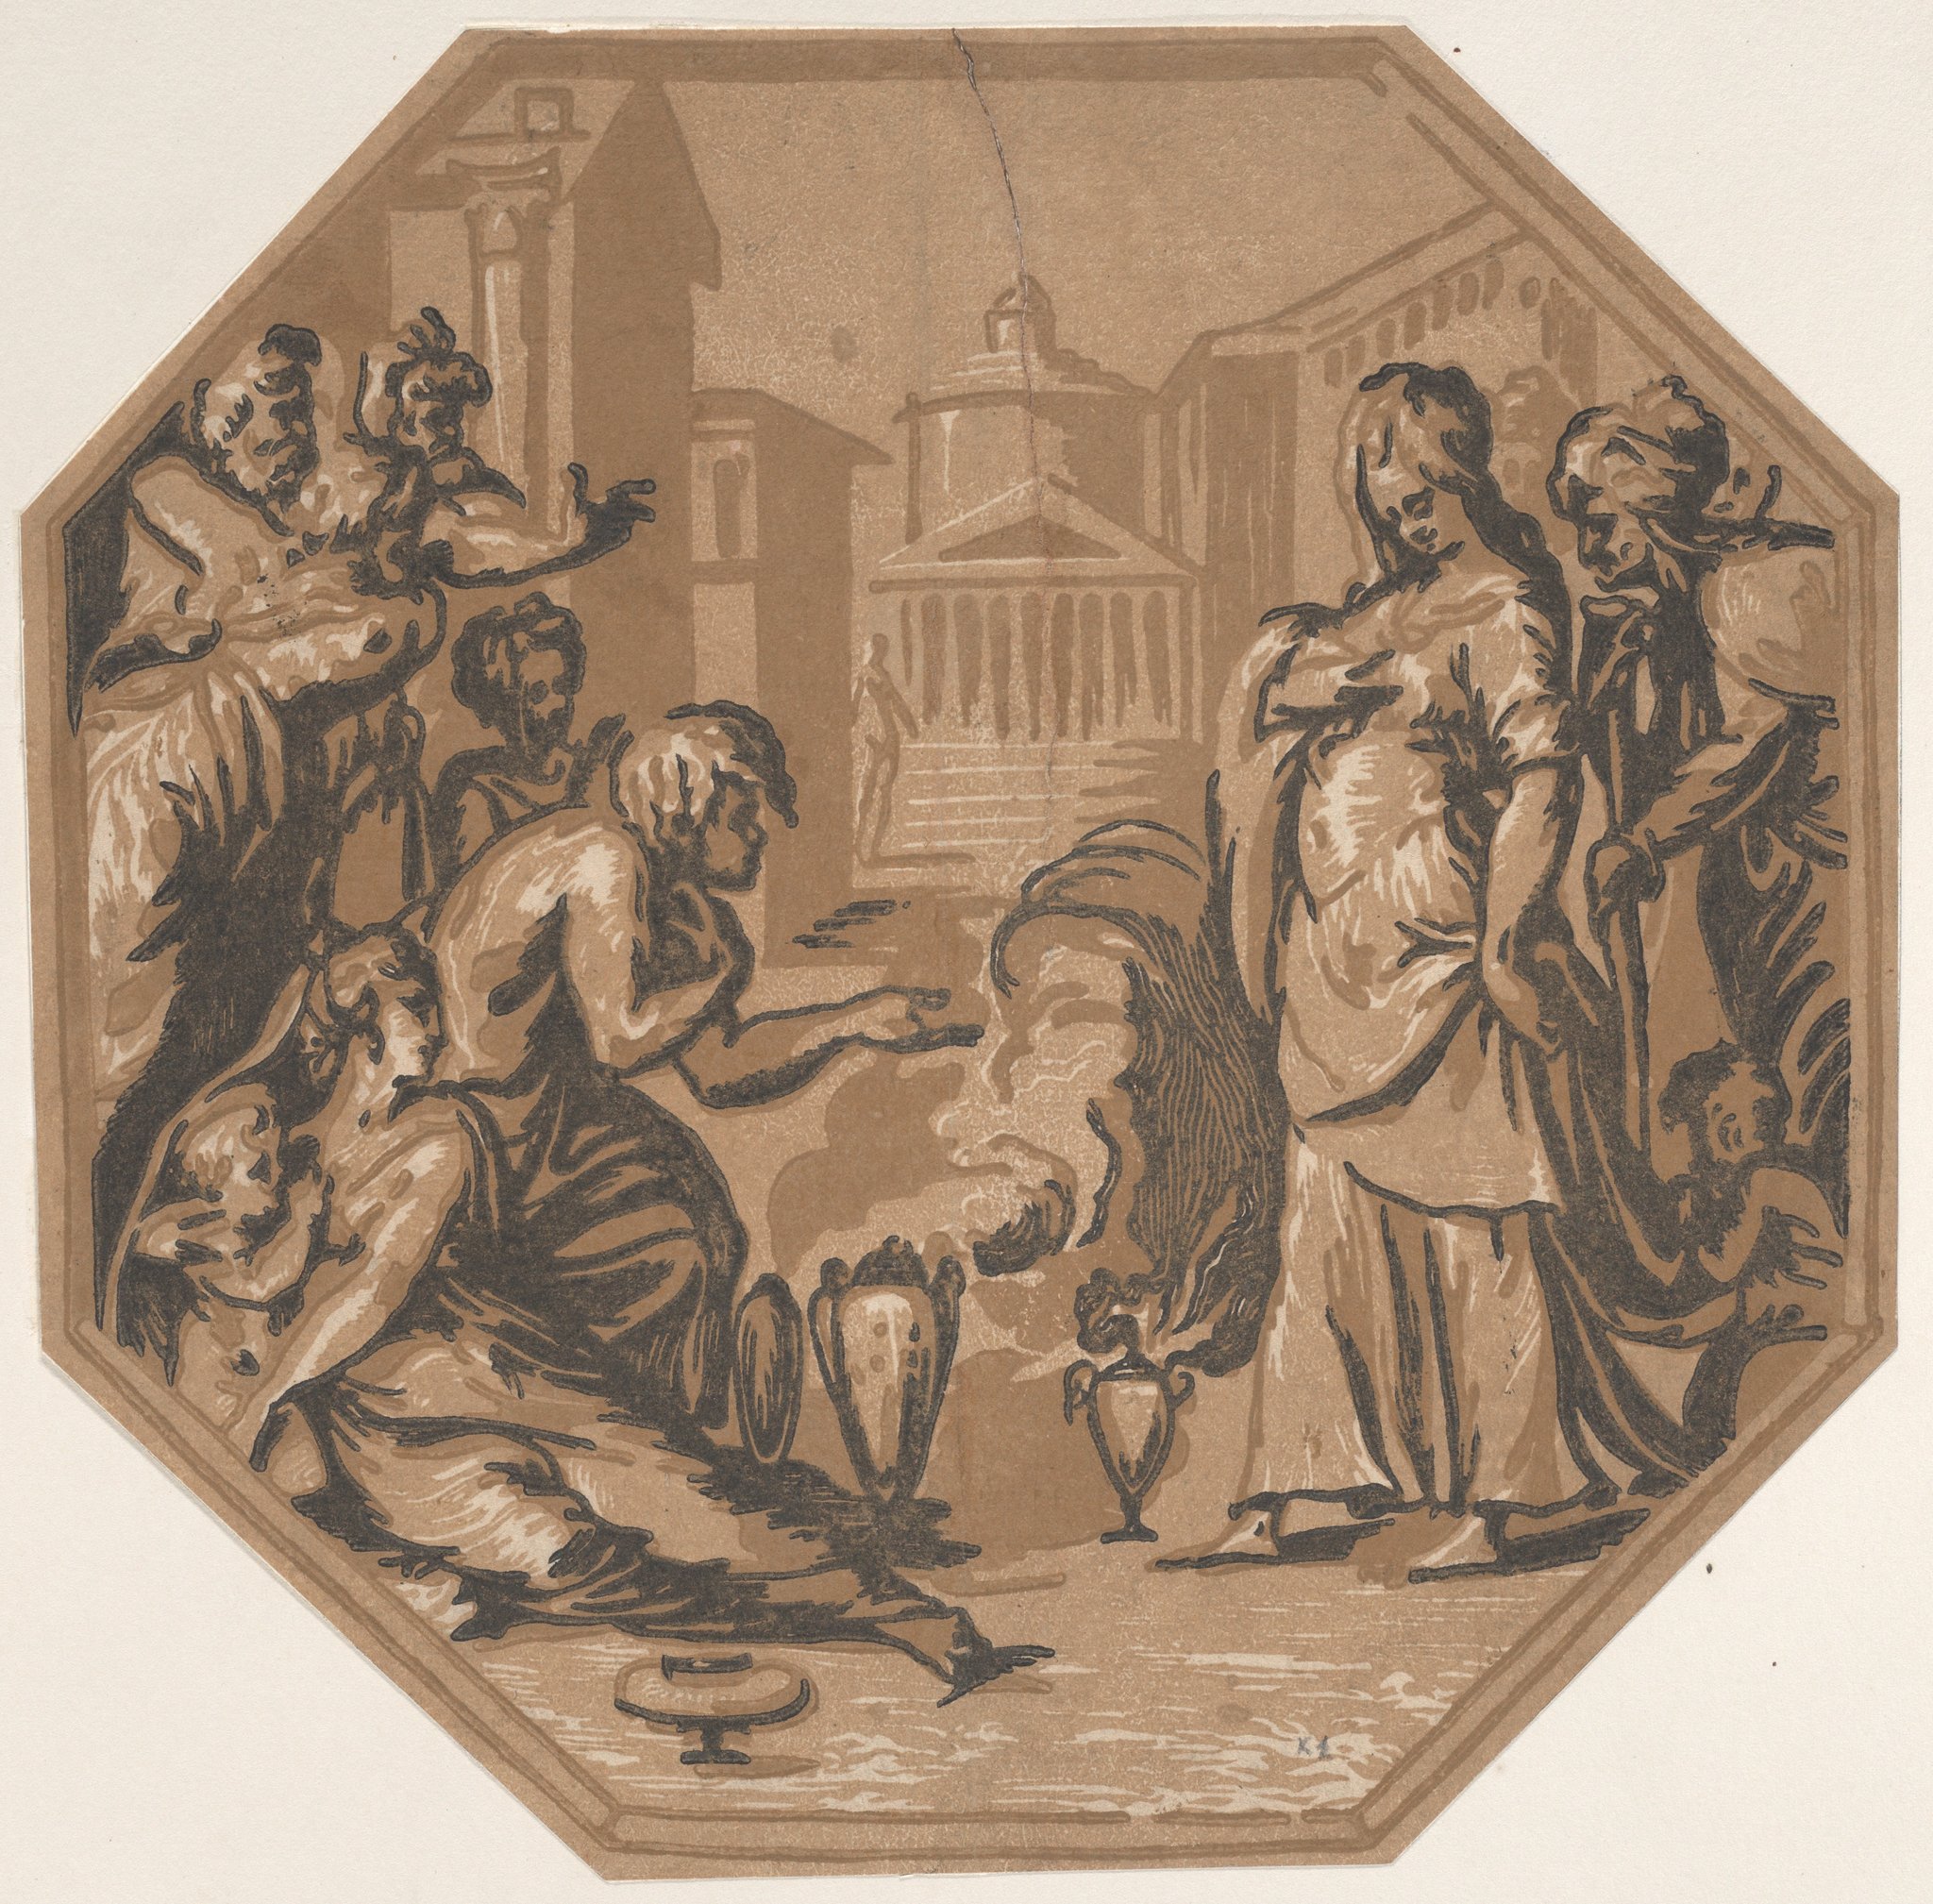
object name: print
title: People paying homage to Psyche's beauty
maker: niccolò vicentino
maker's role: artist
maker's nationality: italian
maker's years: 1510-1550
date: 1540-1550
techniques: woodcut